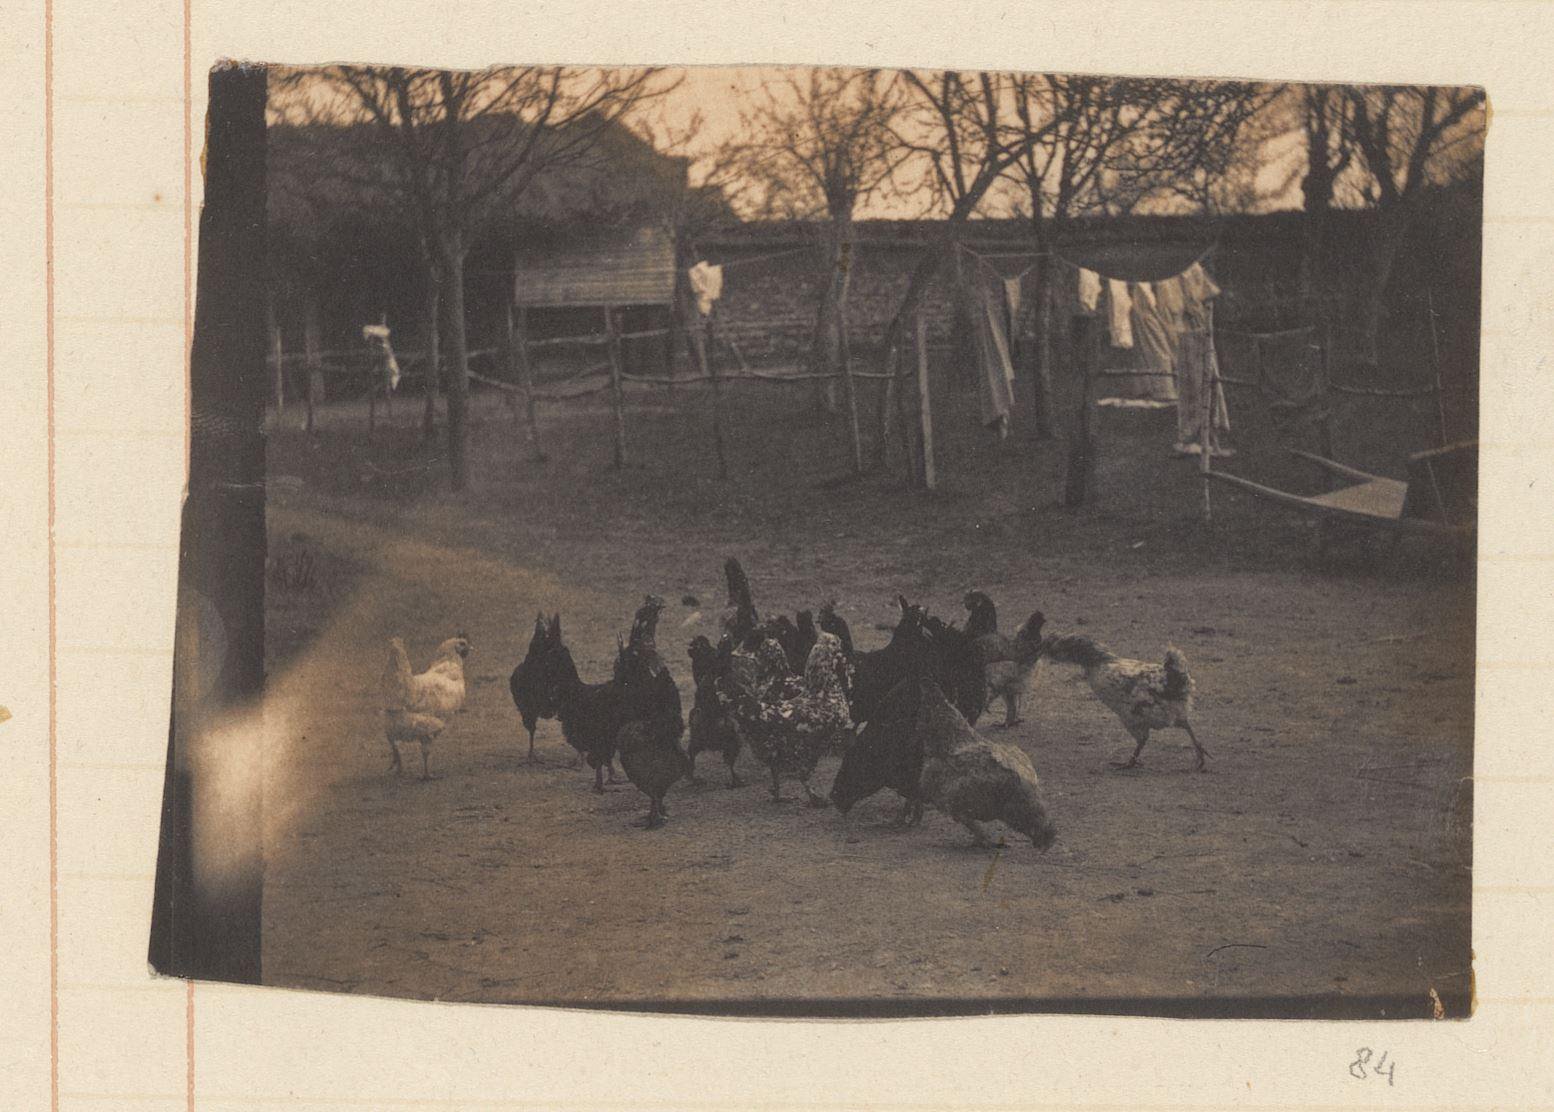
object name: photograph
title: Scharrelende kippen op een boerenerf met op de achtergrond drogend wasgoed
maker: Anonymous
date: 1880-1900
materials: paper, photographic support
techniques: salted paper print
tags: fowl (cock, hen, chicken, etc.), hanging the wash to dry